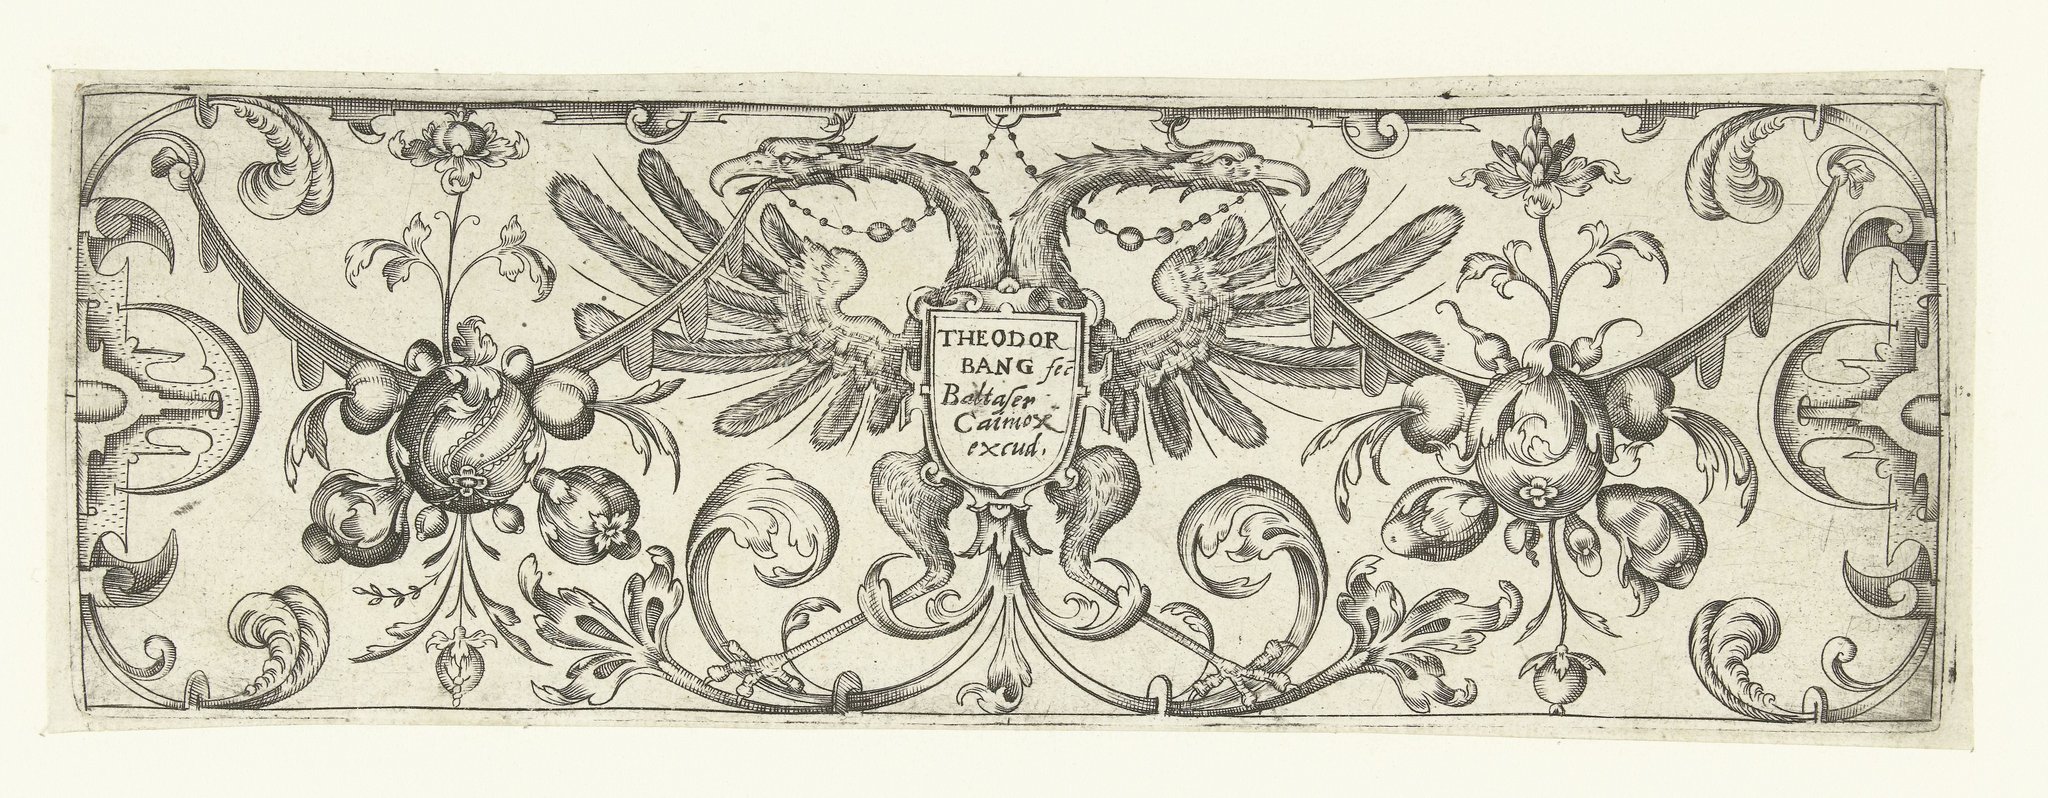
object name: ornament print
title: Friezen met vogels en gestileerde bladranken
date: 1600-1617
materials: paper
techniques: engraving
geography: nuremberg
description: Rand met Schweifwerk, zowel links als rechts hangt een draperie met een trofee van fruit en wortelgewassen. In het schild staat: Theodor Bang fec Baltaser Caimox excud. Titelblad uit serie van 12 bladen met ontwerpen voor edelsmeden.